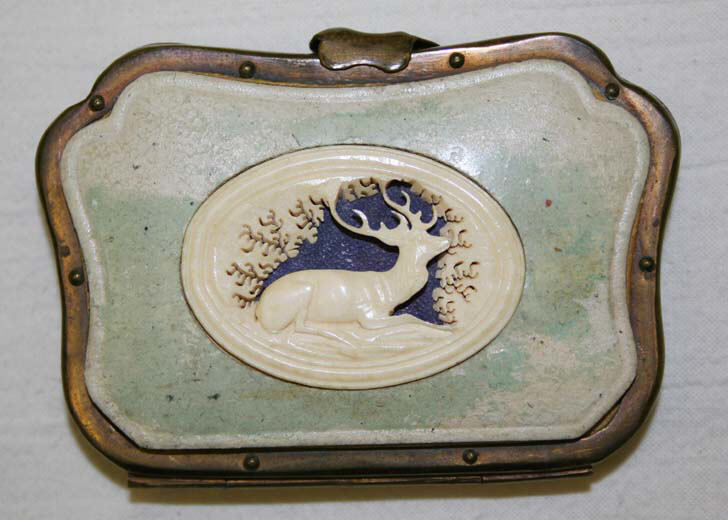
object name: purse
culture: european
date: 1855-1860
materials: leather, metal, paper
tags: deer